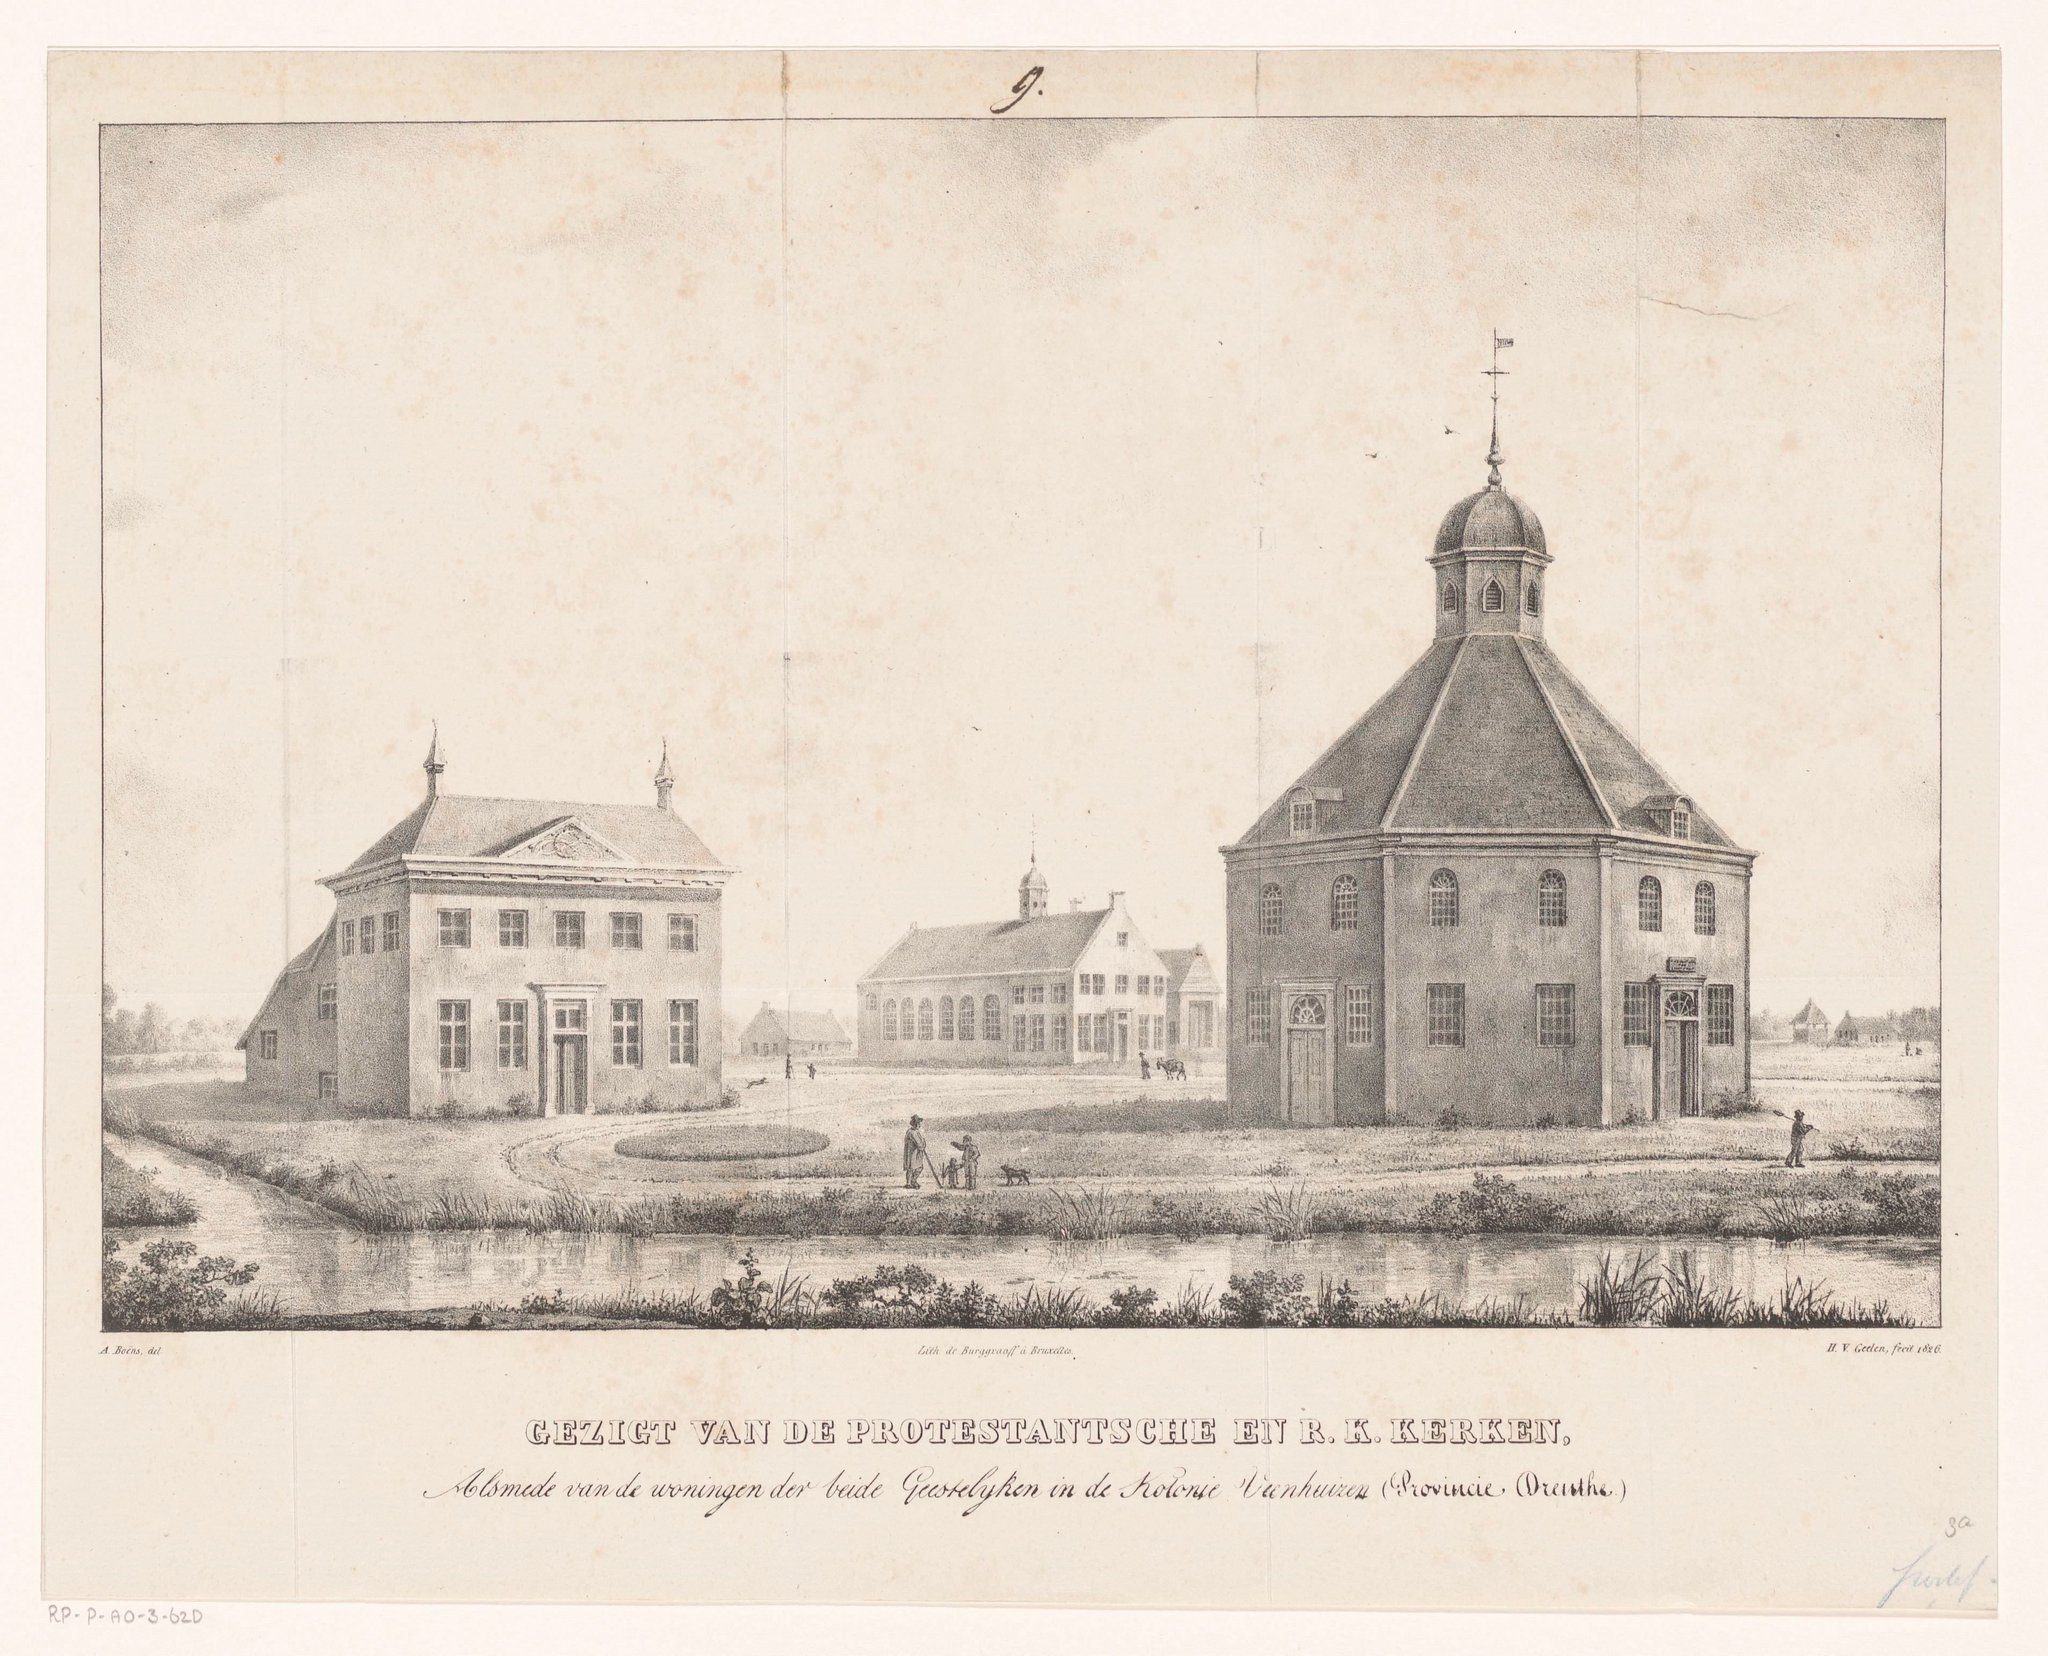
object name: print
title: Gezicht op de kerken en bijhorende woningen in de kolonie Veenhuizen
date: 1827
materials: paper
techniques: lithograph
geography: brussels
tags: maatschappij van weldadigheid, veenhuizen